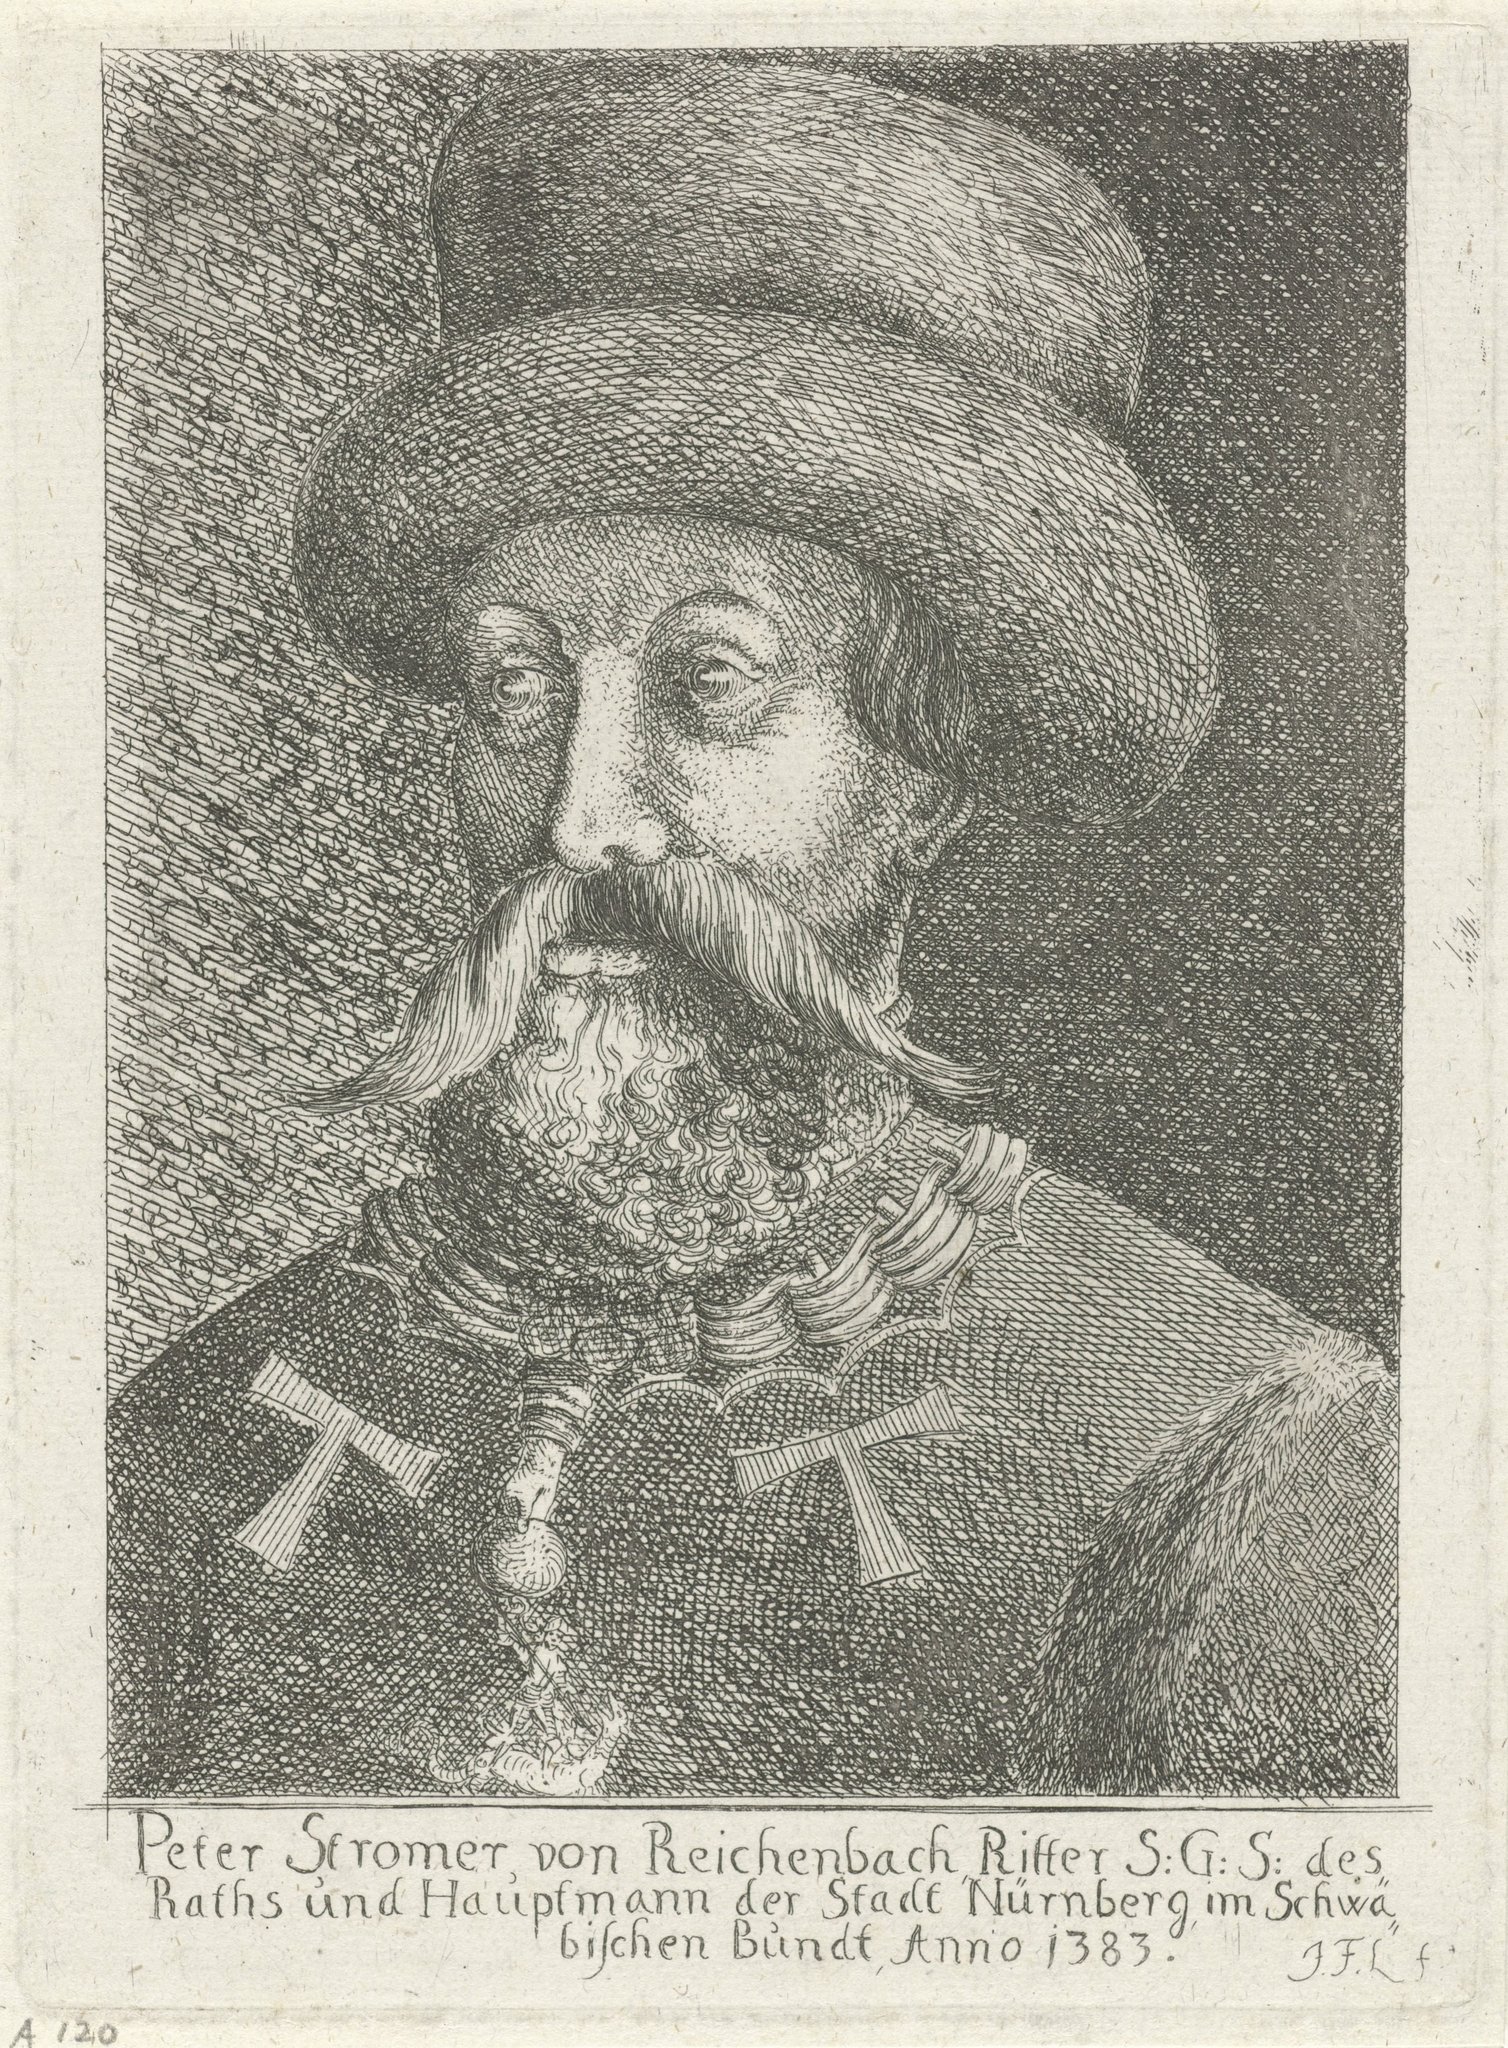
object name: print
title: Portret van Peter Stromer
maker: johann friedrich leonard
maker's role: print maker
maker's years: 1633-1680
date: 1643-1680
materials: paper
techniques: engraving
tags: peter stromer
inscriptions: collector's mark: Lugt 2228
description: Portret van Peter Stromer, raadsheer en koopman te Neurenberg.